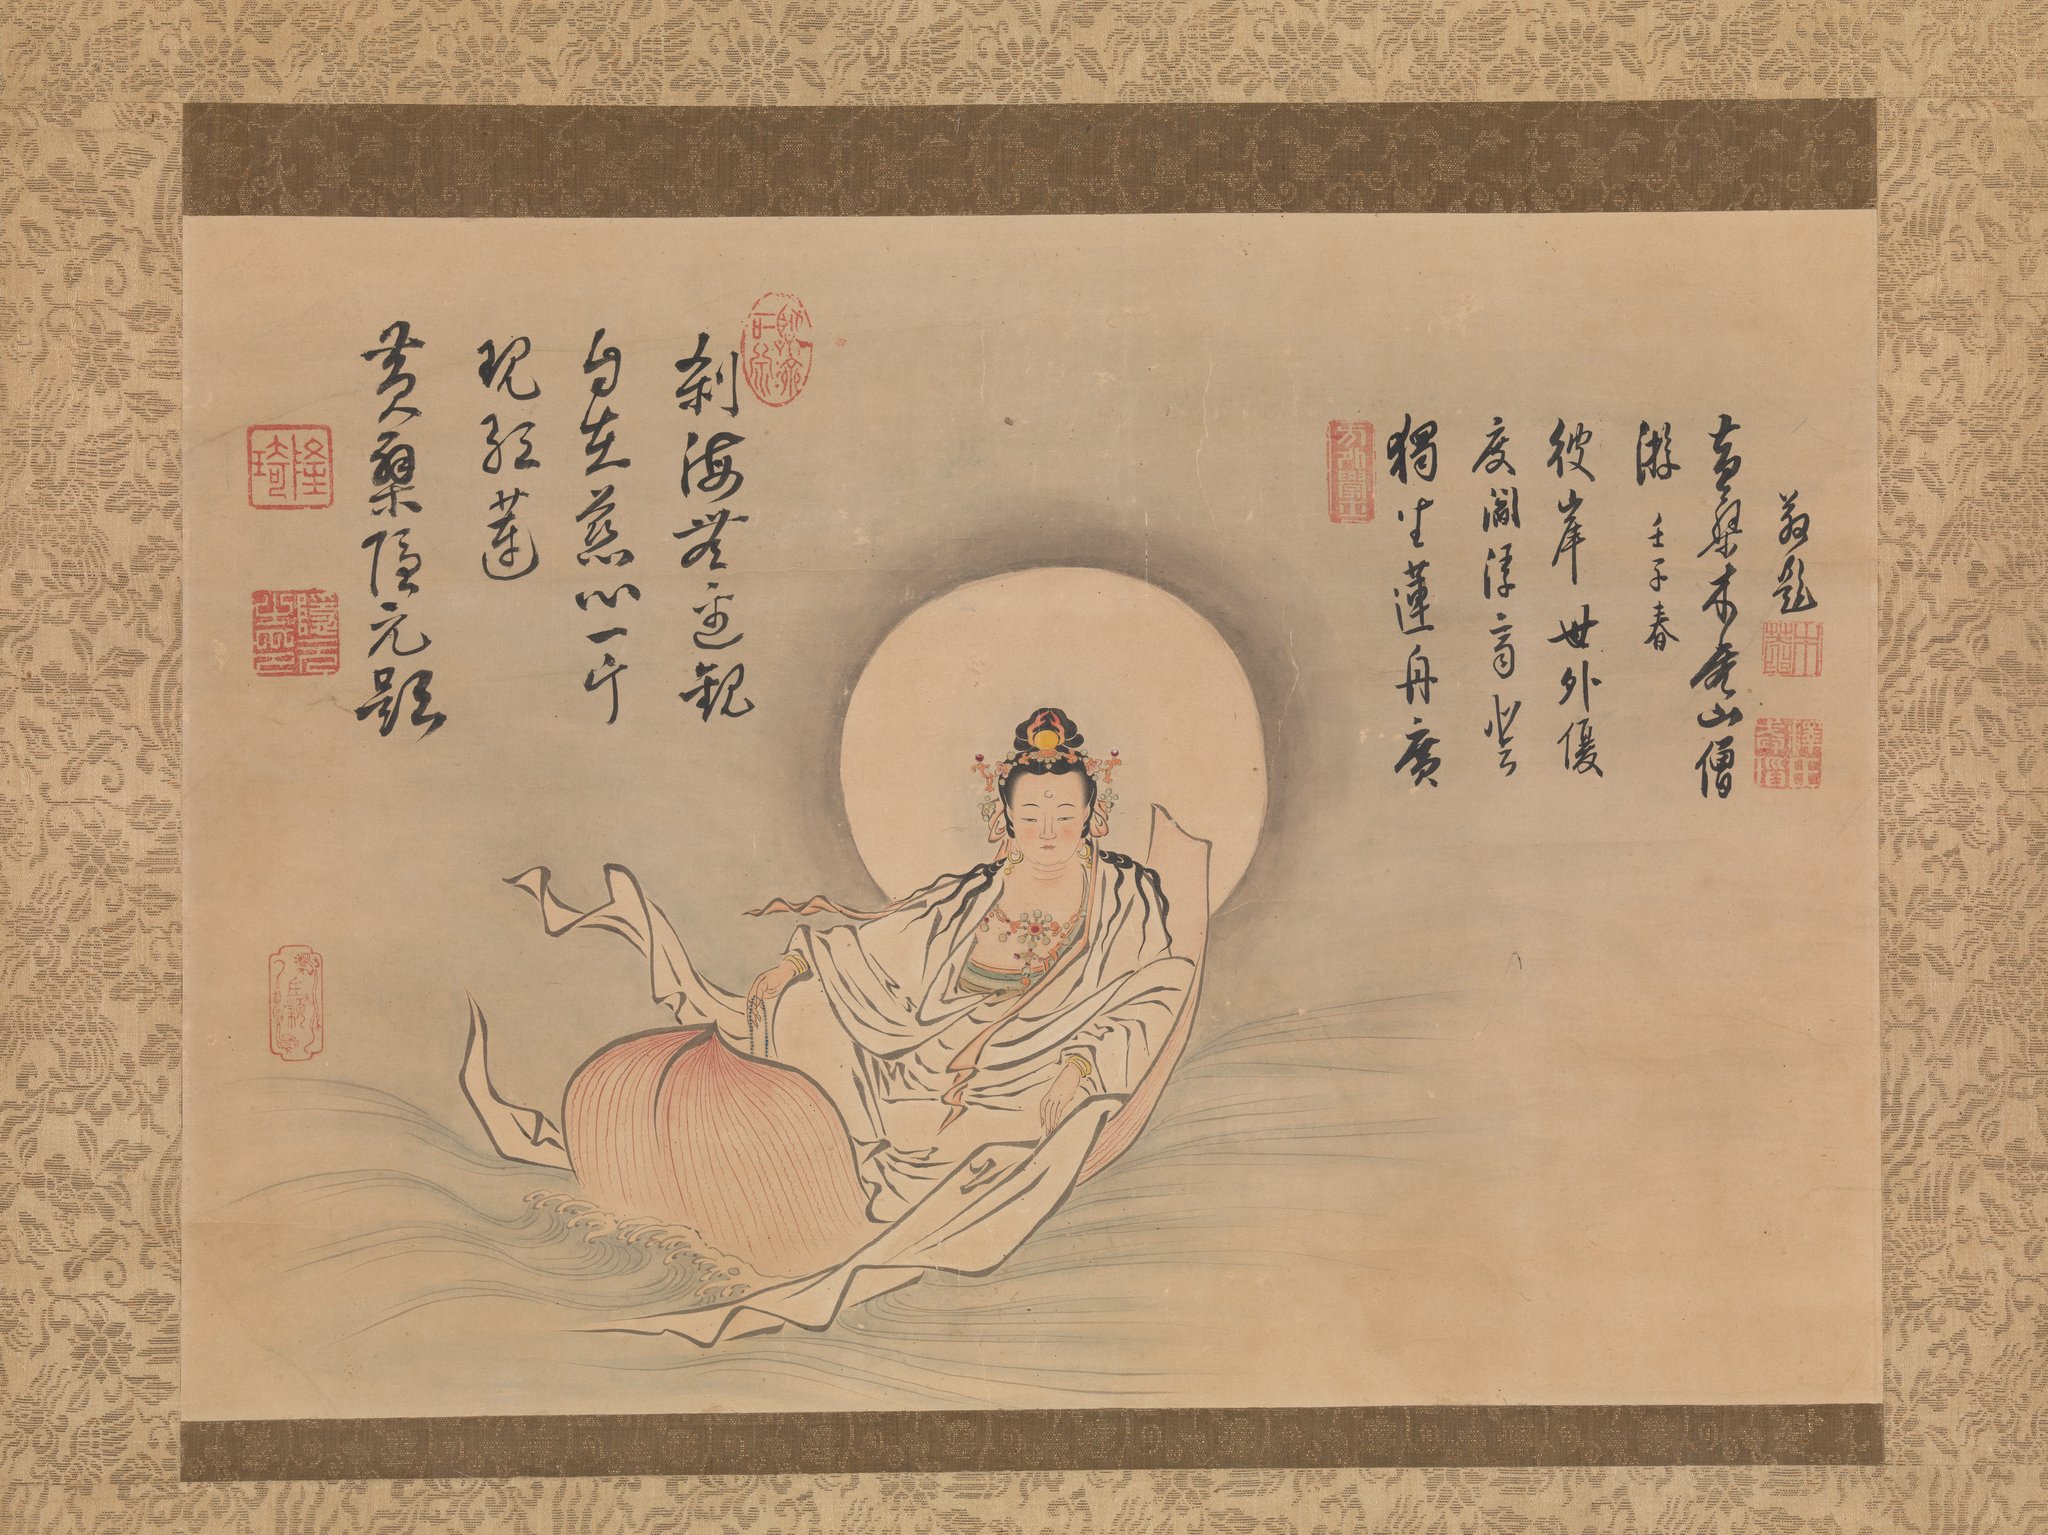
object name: hanging scroll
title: Kannon on a Lotus Petal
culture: japanese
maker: shōzan gen’yō 照山元瑶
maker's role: artist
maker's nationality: japanese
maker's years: 1634-1727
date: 1672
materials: ink, paper